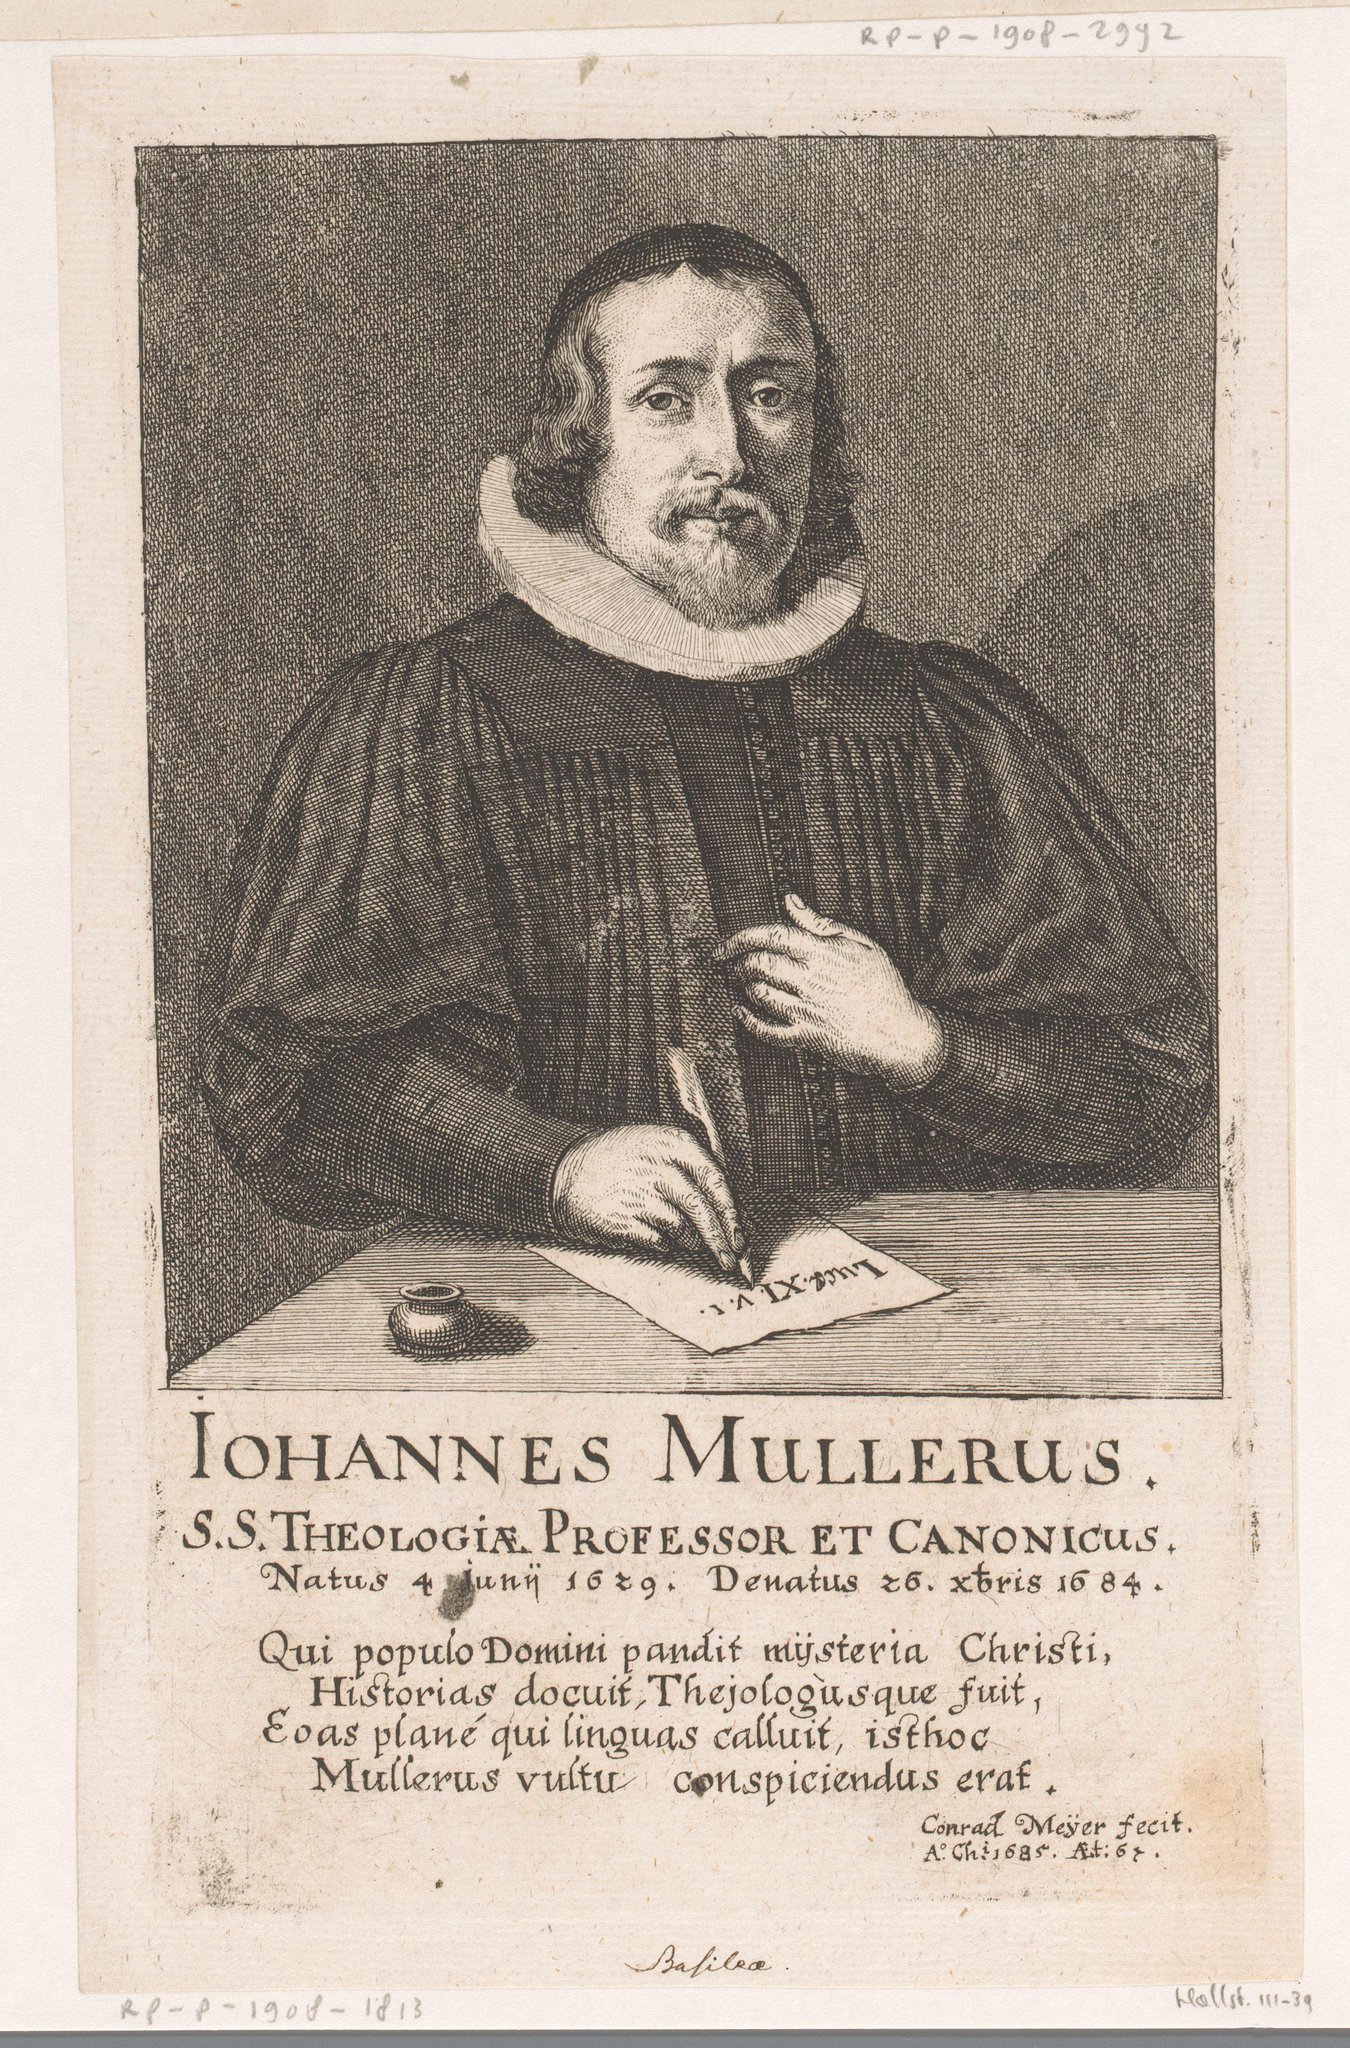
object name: print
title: Portretten van priesters van Zürich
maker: conrad meyer (i)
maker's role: painter, print maker, publisher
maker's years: 1618-1689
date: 1685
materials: paper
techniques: engraving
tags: theologian, historical persons, writing accessories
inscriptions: collector's mark: Lugt 2228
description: Onderdeel van een serie van 62 portretten van priesters en theologen van Zürich. Zie Hollstein German 111, 1-41.